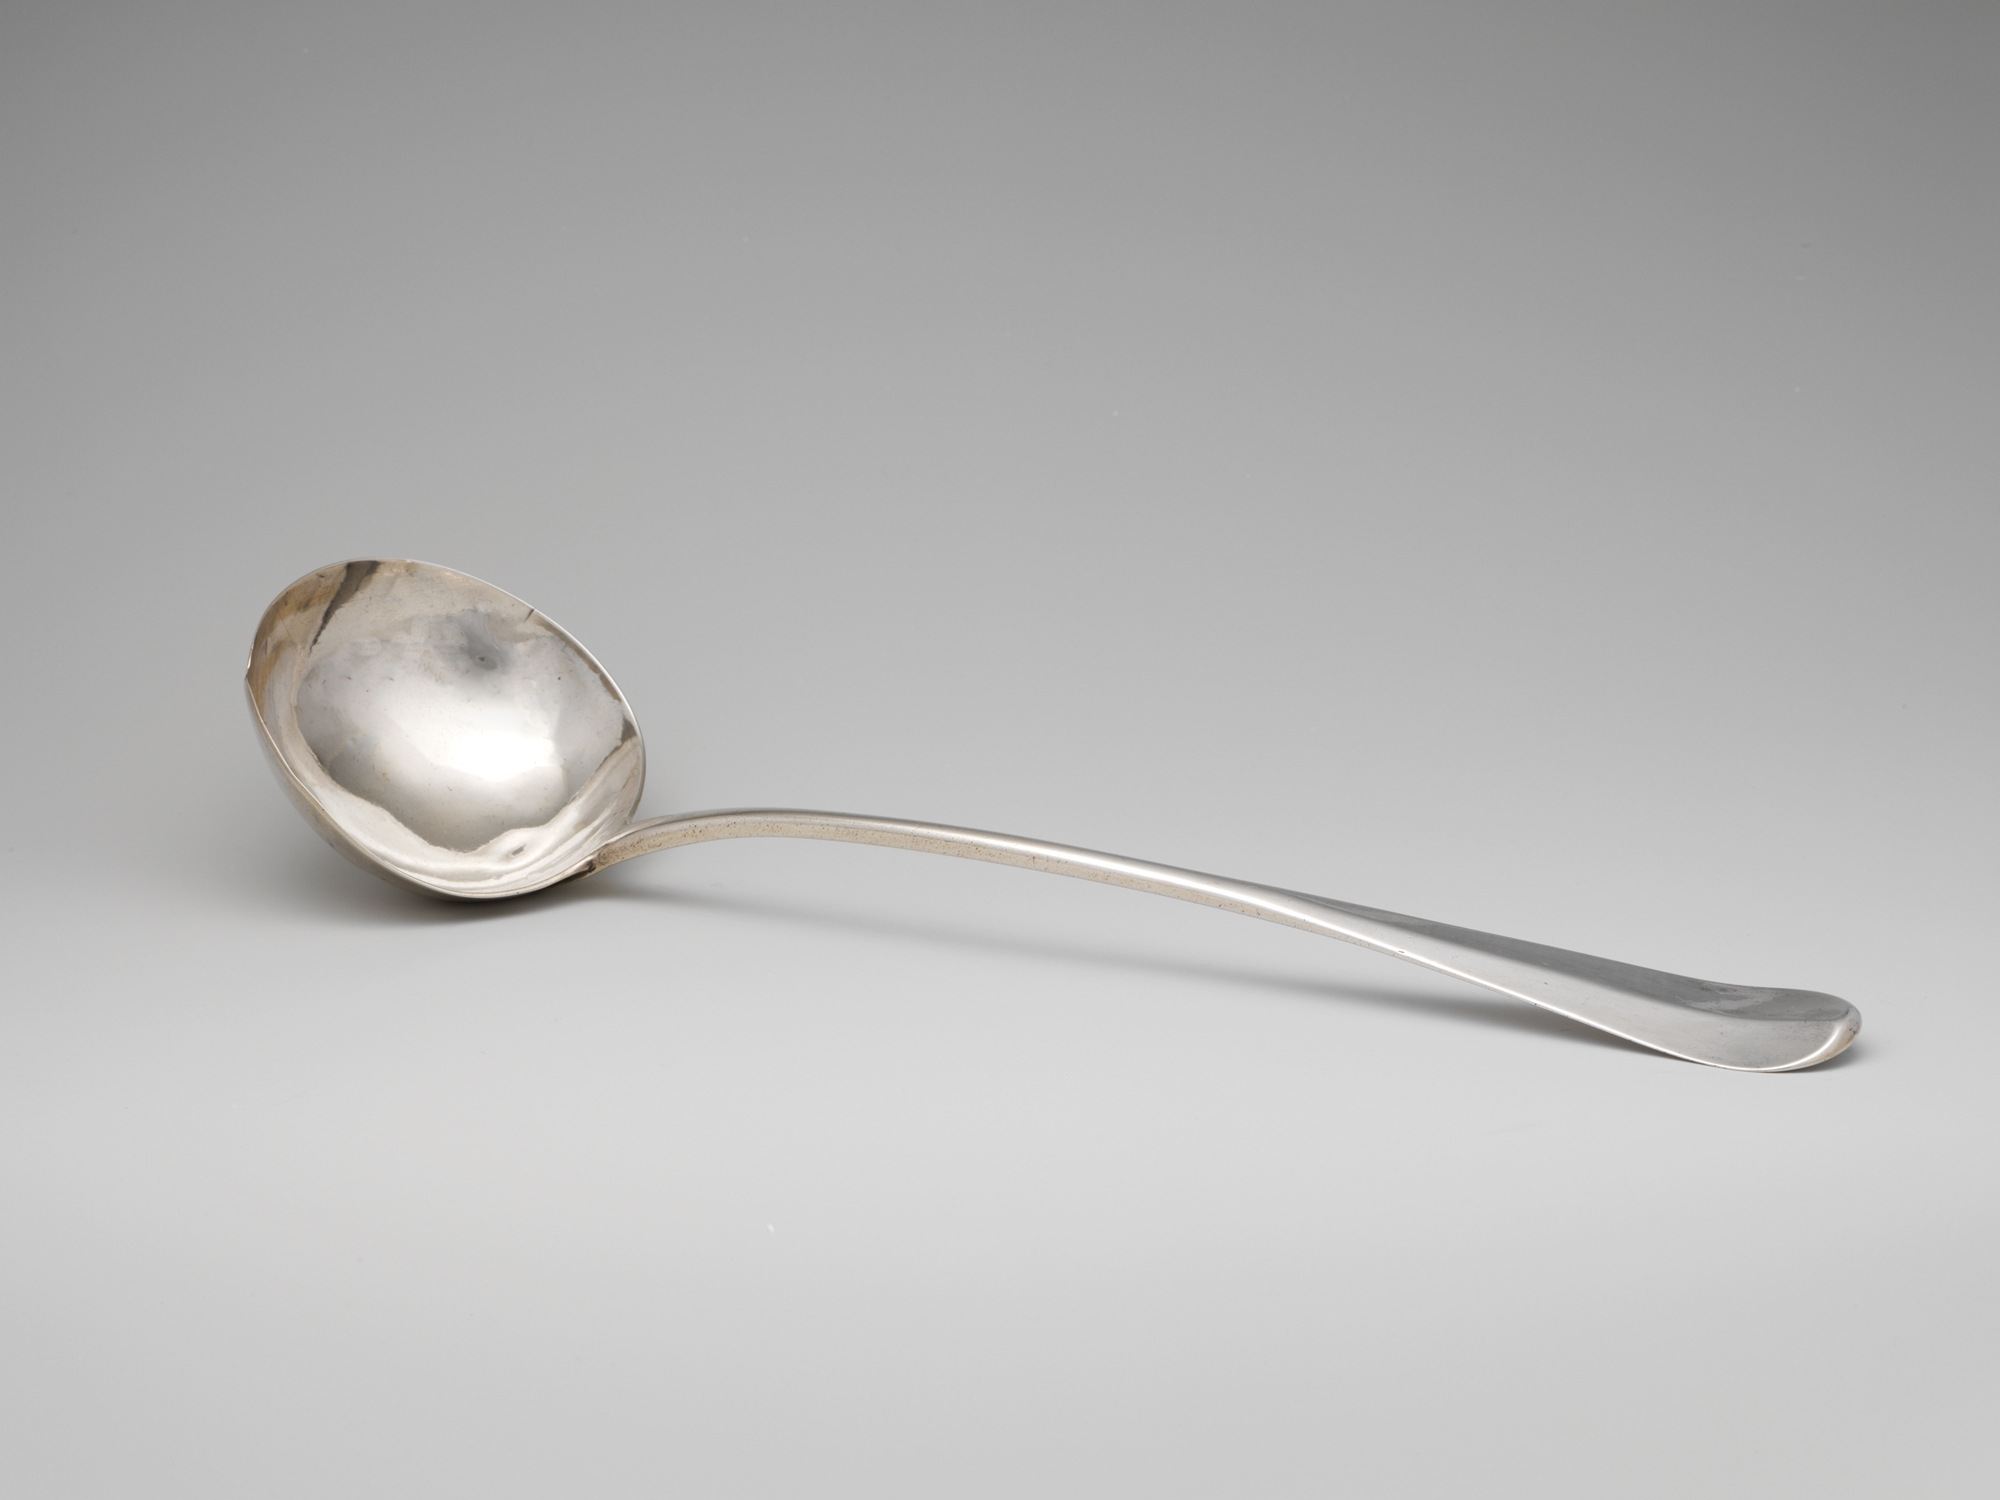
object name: ladle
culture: american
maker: william hollingshead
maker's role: maker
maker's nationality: american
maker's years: 1723-1808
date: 1755-1775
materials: silver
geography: united states